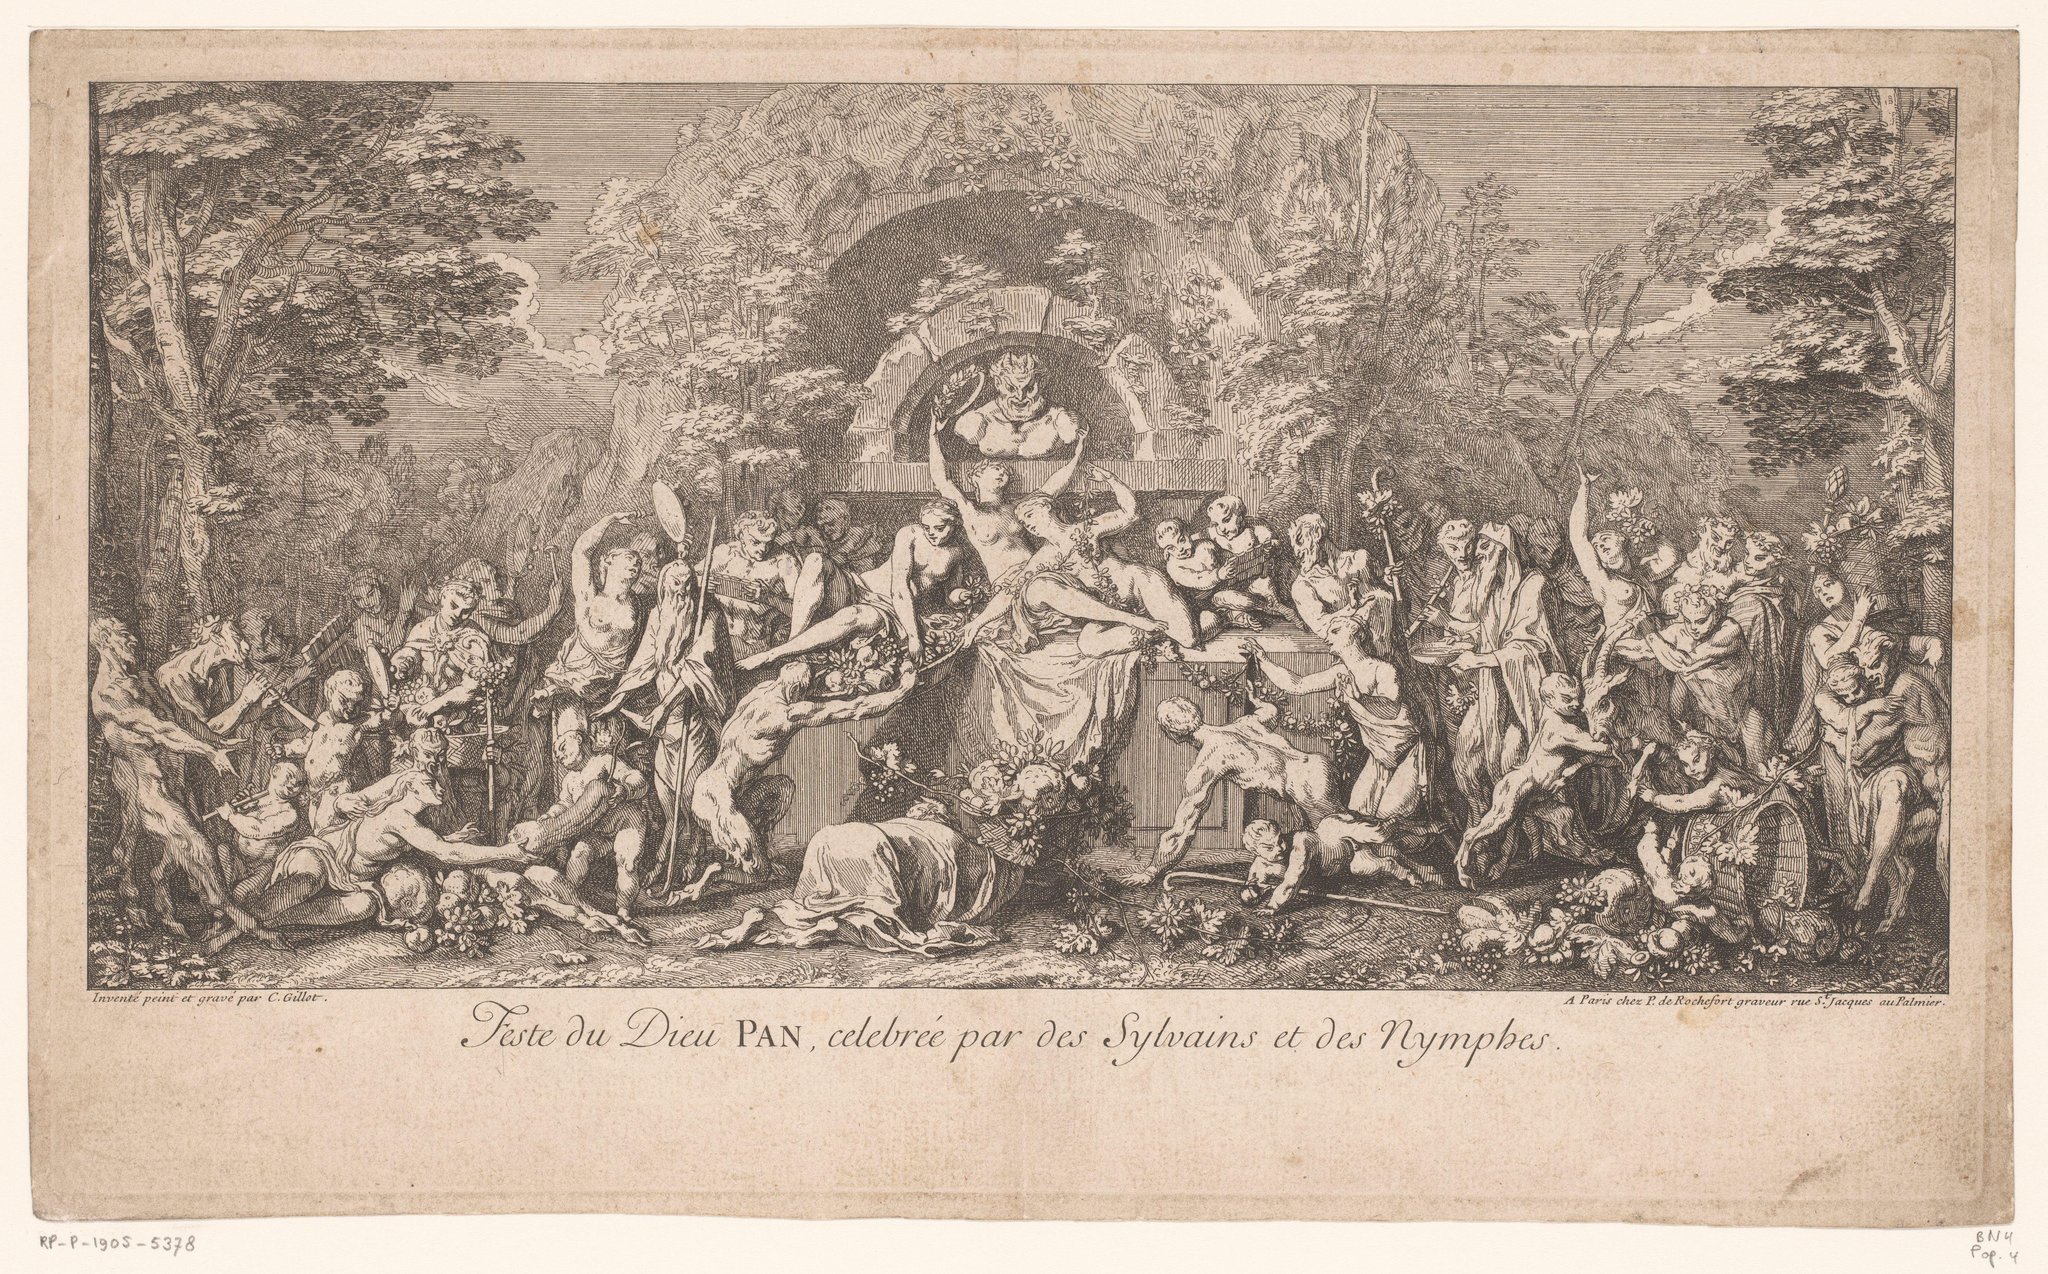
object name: print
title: Grieks-Romeinse feesten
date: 1683-1722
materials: paper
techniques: etching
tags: (story of) pan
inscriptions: collector's mark: Lugt 2228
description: Maakt deel uit van een vierdelige serie met Grieks-Romeinse vieringen.